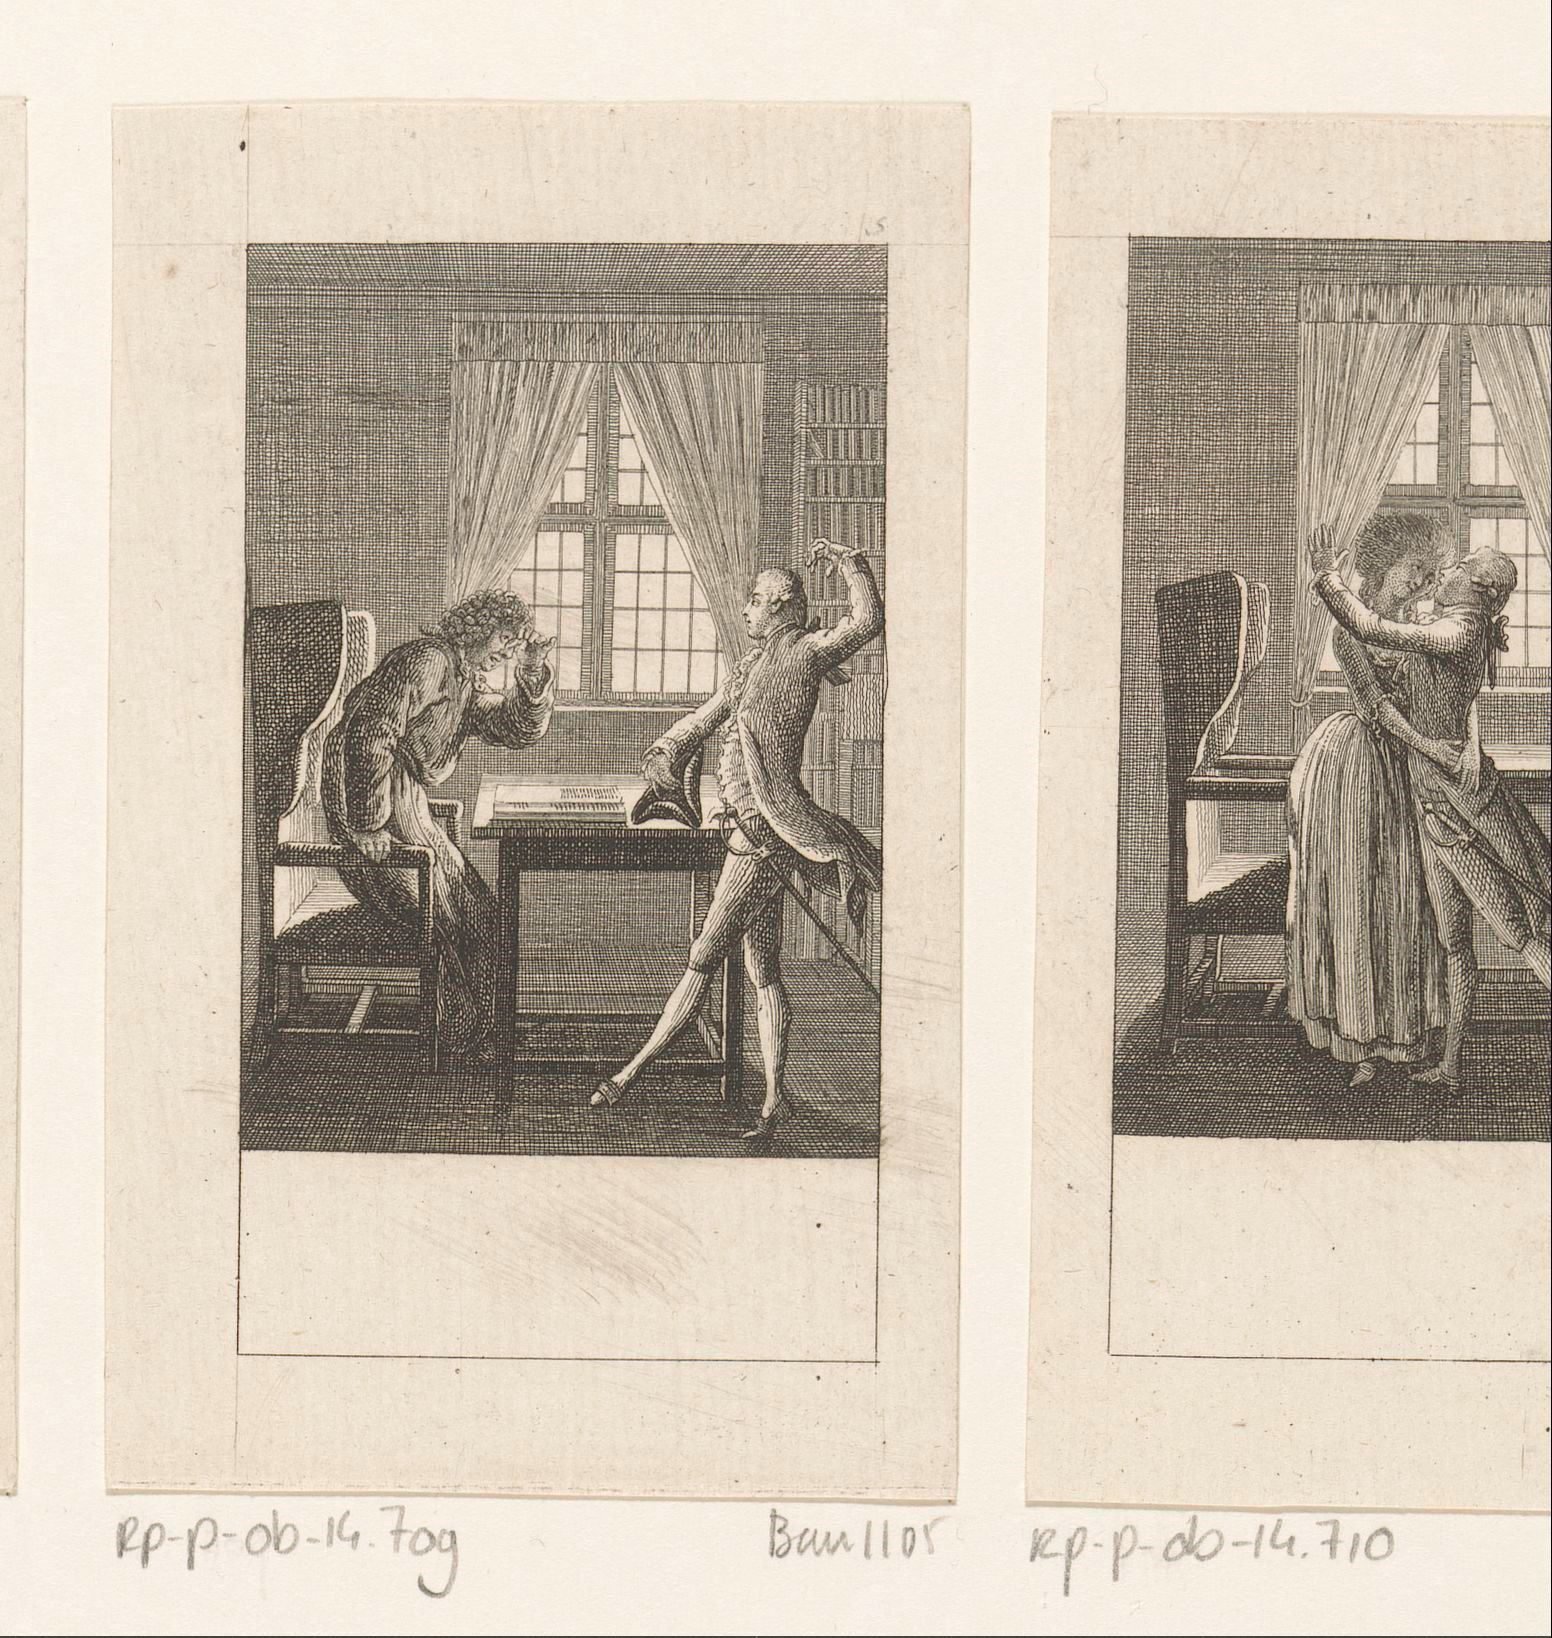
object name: print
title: Linse op het kantoor van Storr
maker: daniel nikolaus chodowiecki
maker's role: draughtsman, print maker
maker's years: 1726-1801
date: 1784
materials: paper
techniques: etching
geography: berlin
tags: literature, book-keeping, accountant, conversation, dialogue; conversation piece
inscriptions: collector's mark: Lugt 2228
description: Vervaardigd voor Christian Friedrich Bretzners 'Eheprocurator'. Latere staat gebruikt voor: Konigl. Grosbrit. Genealogischen Kalender auf das Jahr 1785. Lauenburg: J. G. Berenberg, 1784.